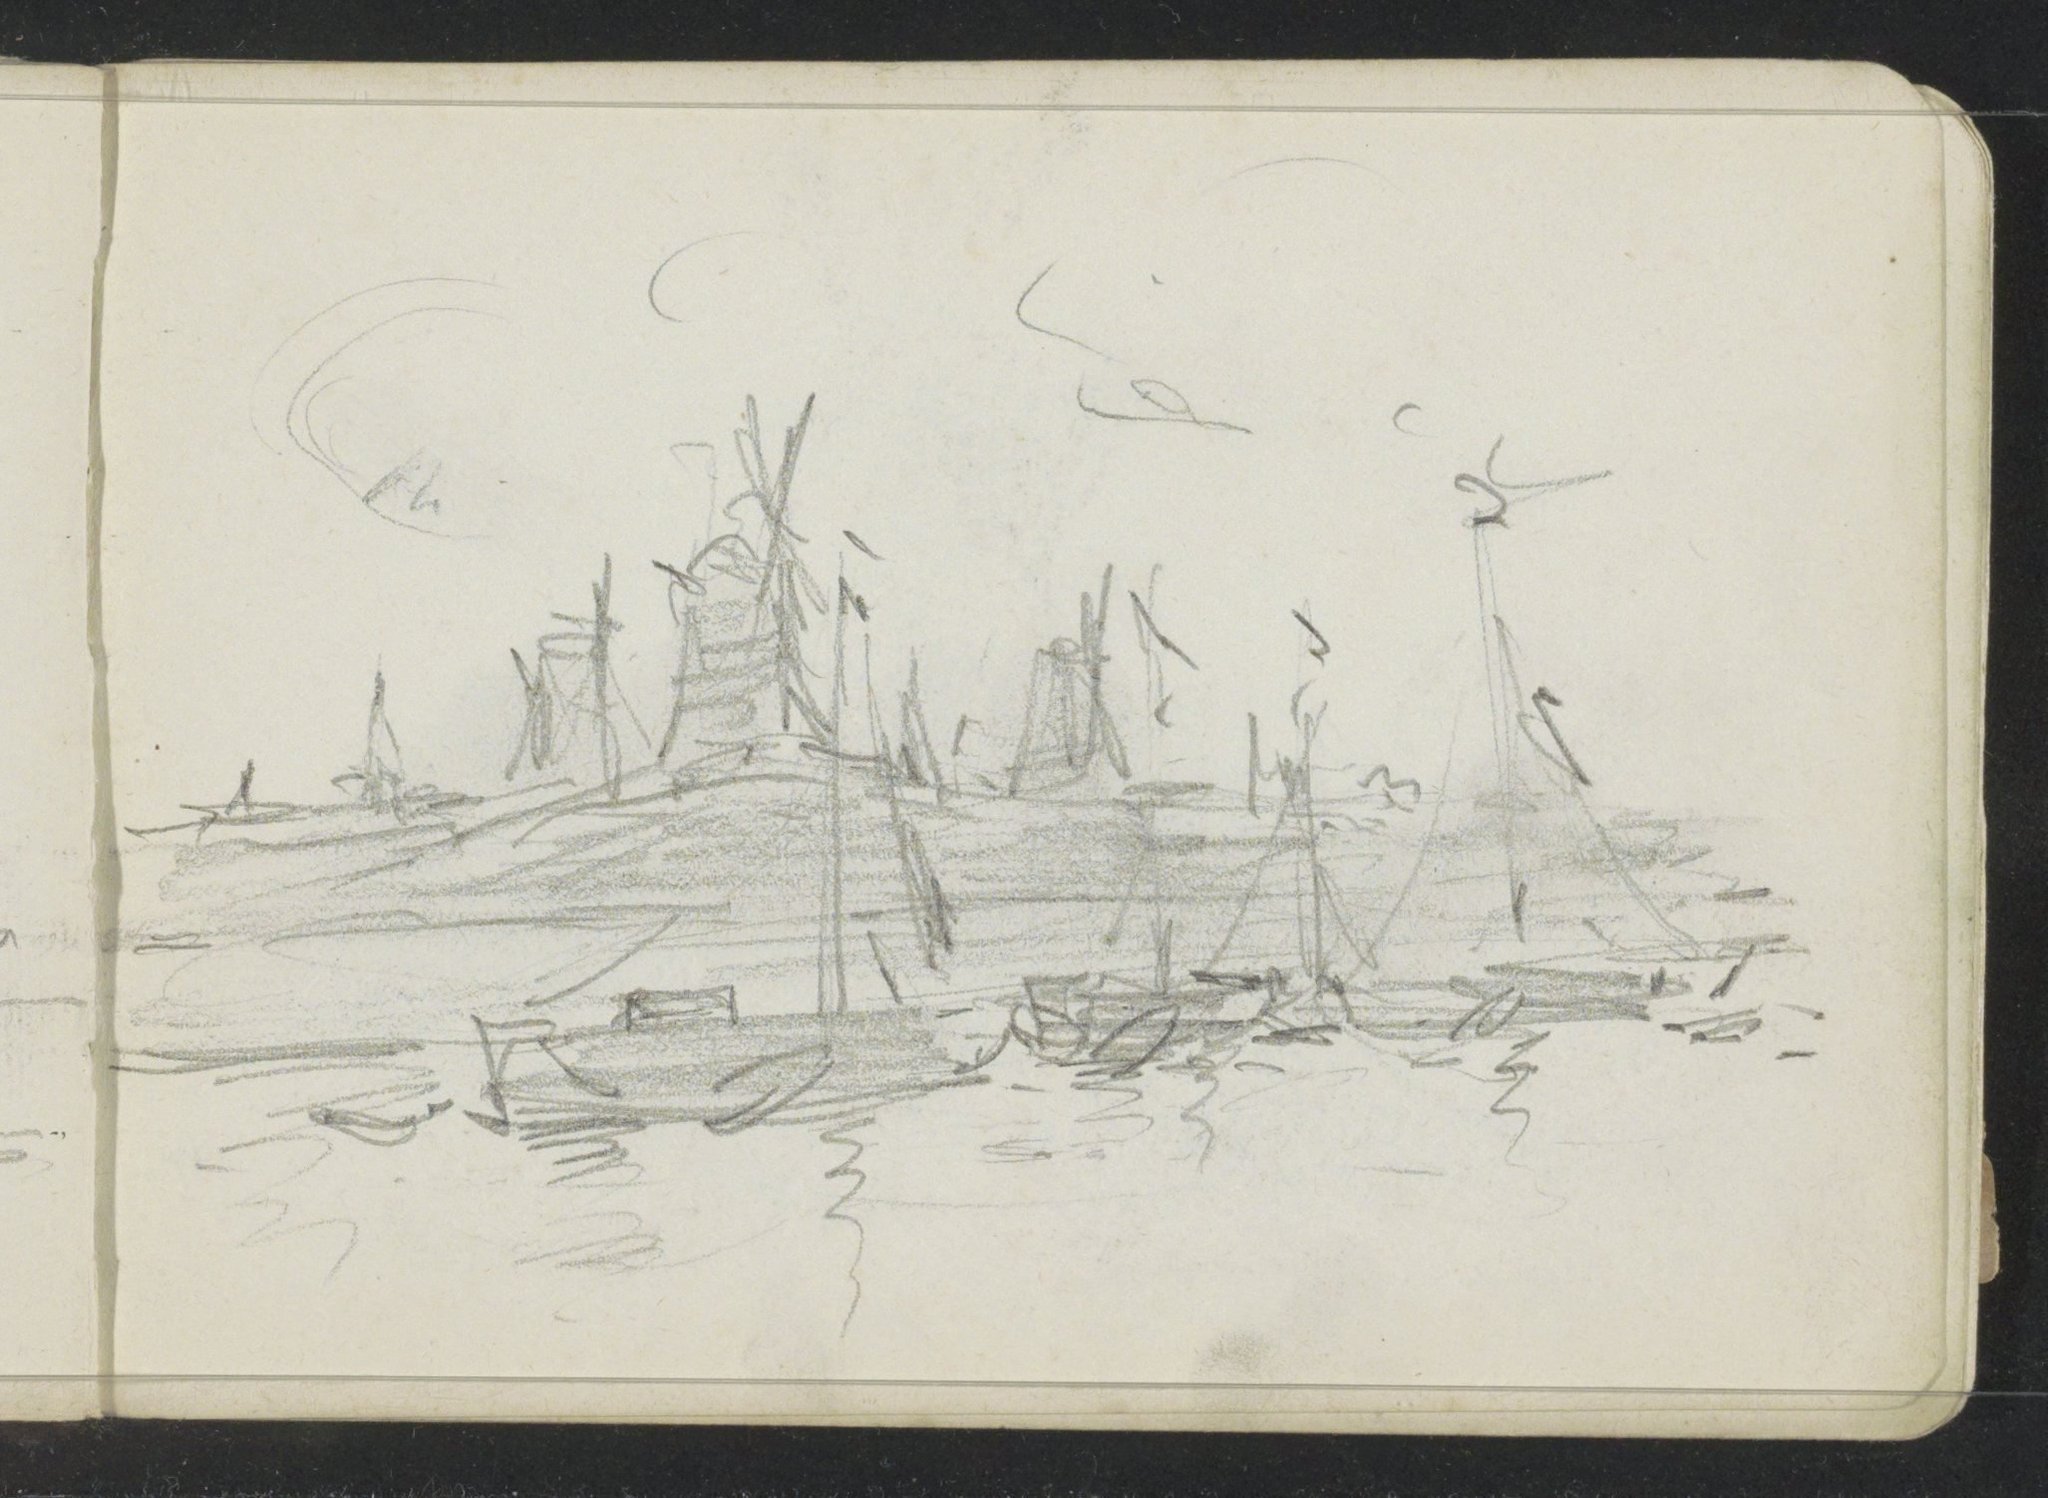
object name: sketchbook leaf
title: Zeilboten voor een kust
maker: johanna van de kamer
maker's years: 1873-1922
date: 1883-1922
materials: paper, pencil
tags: sailing-ship, sailing-boat, windmill in landscape, coast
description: Op de achtergrond windmolens op een heuvel. Blad 17 recto uit een schetsboek met 27 bladen.